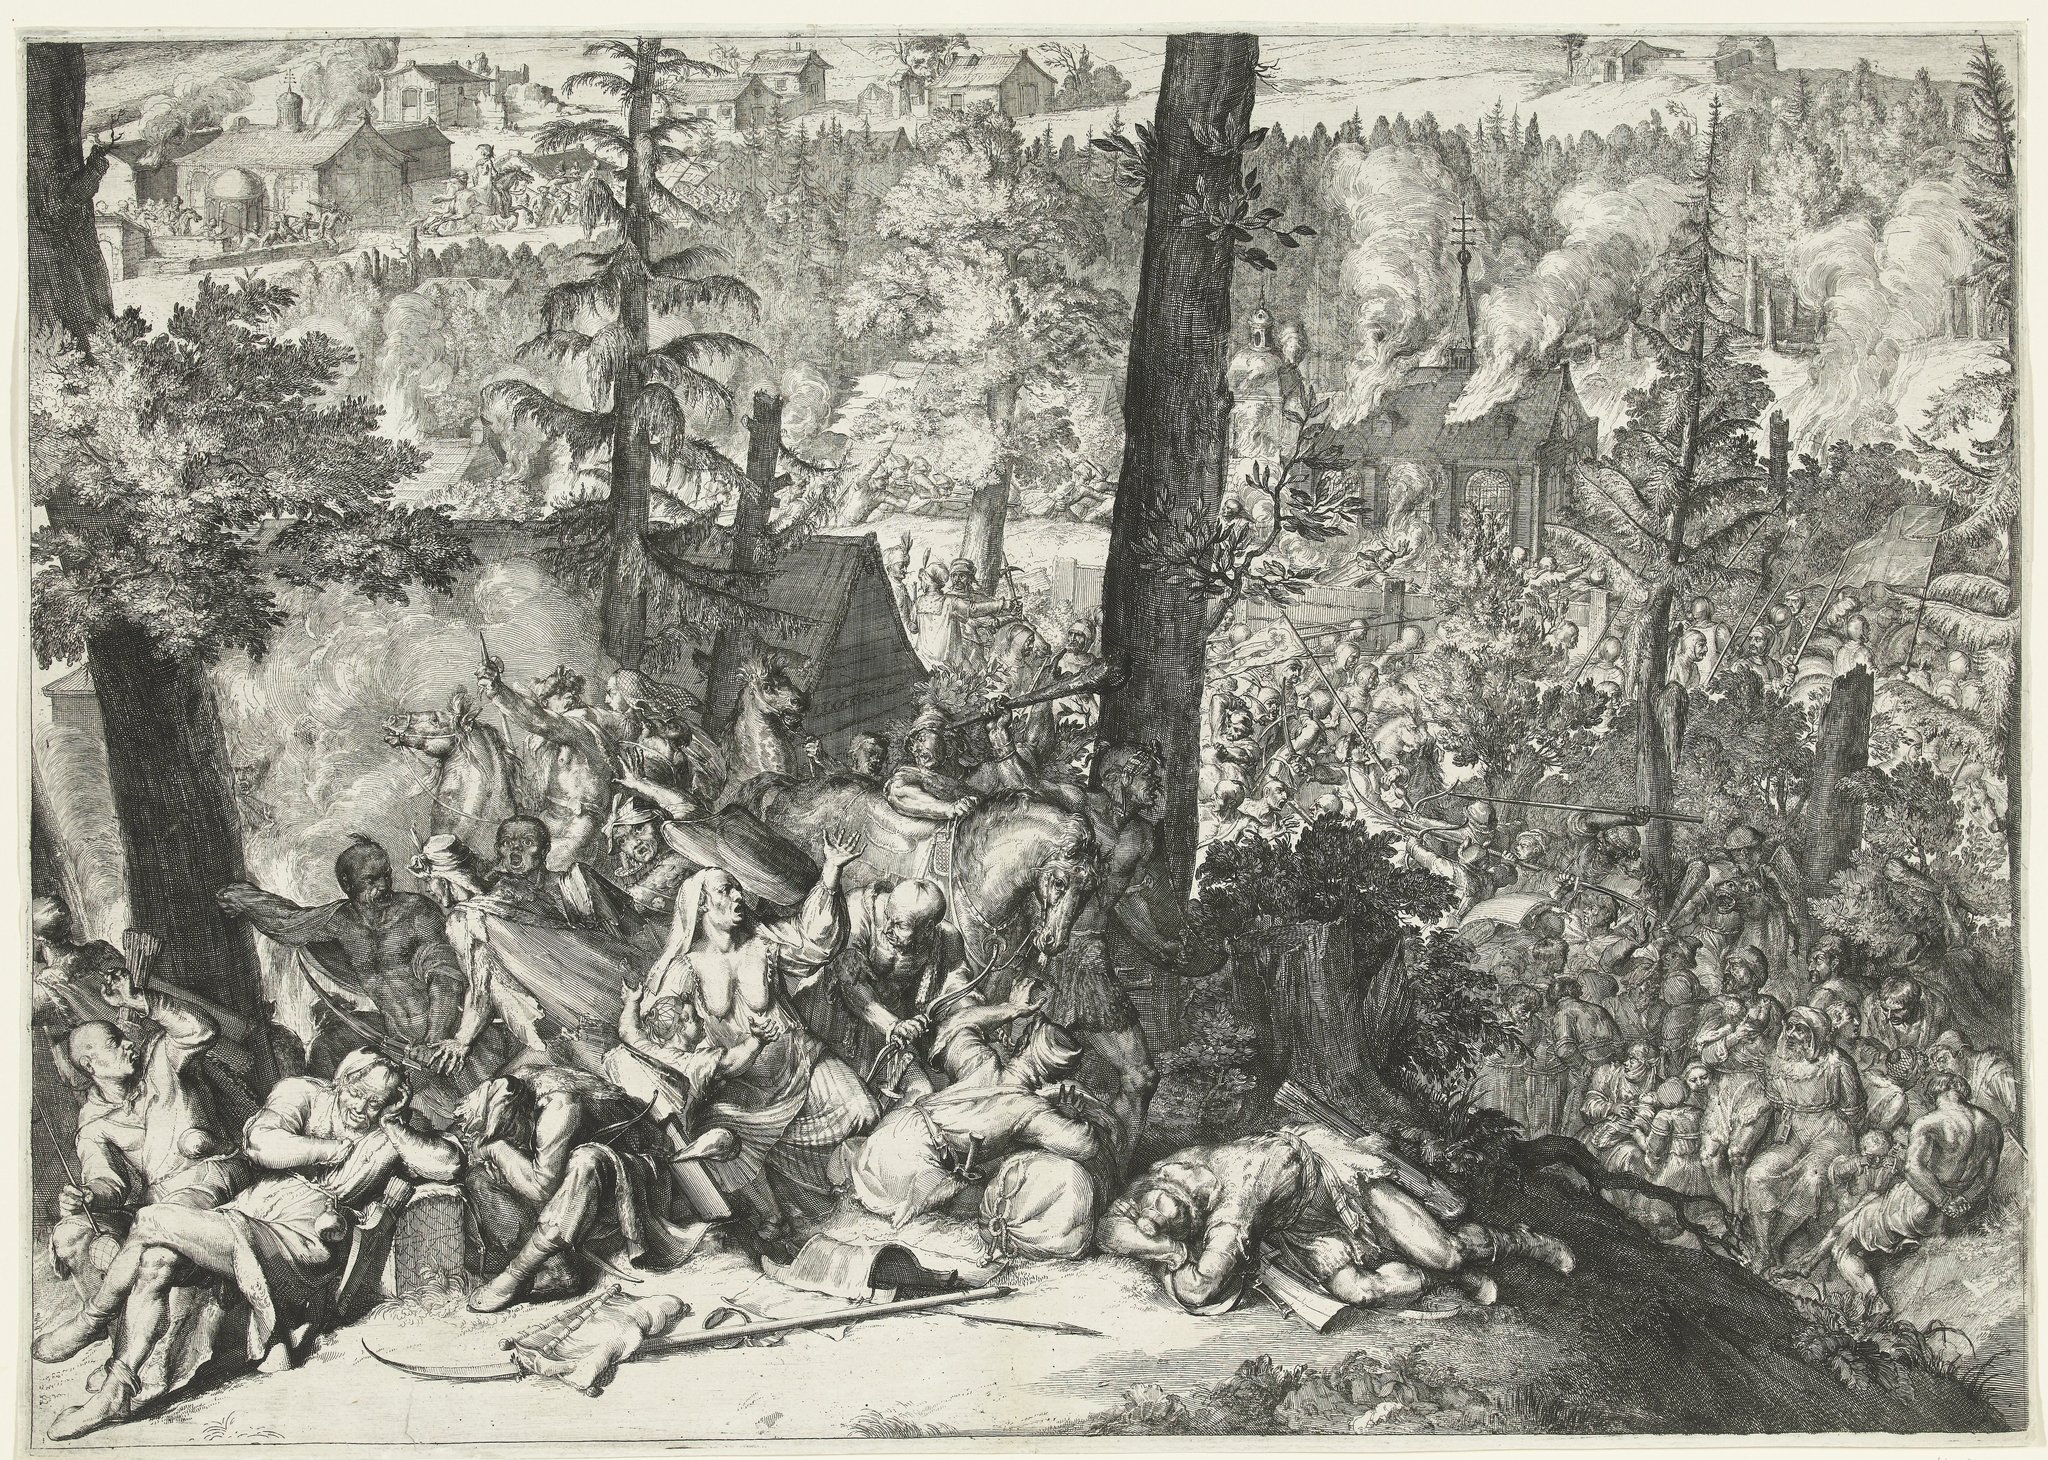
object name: print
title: Overwinning van hertog Karel V van Lotharingen en markgraaf Lodewijk Willem van Baden-Baden op de Turken, 1687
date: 1675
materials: paper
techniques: etching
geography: netherlands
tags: on fire, ablaze, battle, fighting in general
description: Prent is een van vier bladen die samen één voorstelling vormen. Op het eerste blad links in de achtergrond Lviv in Ukraine met hoog op de heuvel het kasteel. Een stuk ervoor is de rivier de Dnjestr te zien en rechtsonder de vesting bij Komarno. Op het tweede blad geheel links Komarno waar gevochten wordt. Op dit derde blad (dat onder het eerste past) strijdgewoel en gevangen. Op het vierde blad (dat onder het tweede blad thuishoort) is Jan Sobieski te vinden, te paard achter een priester die bezwerend een kruis hooghoudt. Hij wordt omringd door de Poolse gevleugelde huzaren, gepantserde cavalerie en Pools-Hongaarse dragonders, vechtend tegen een Tartaarse troepenmacht bijgestaan door Kozakken.